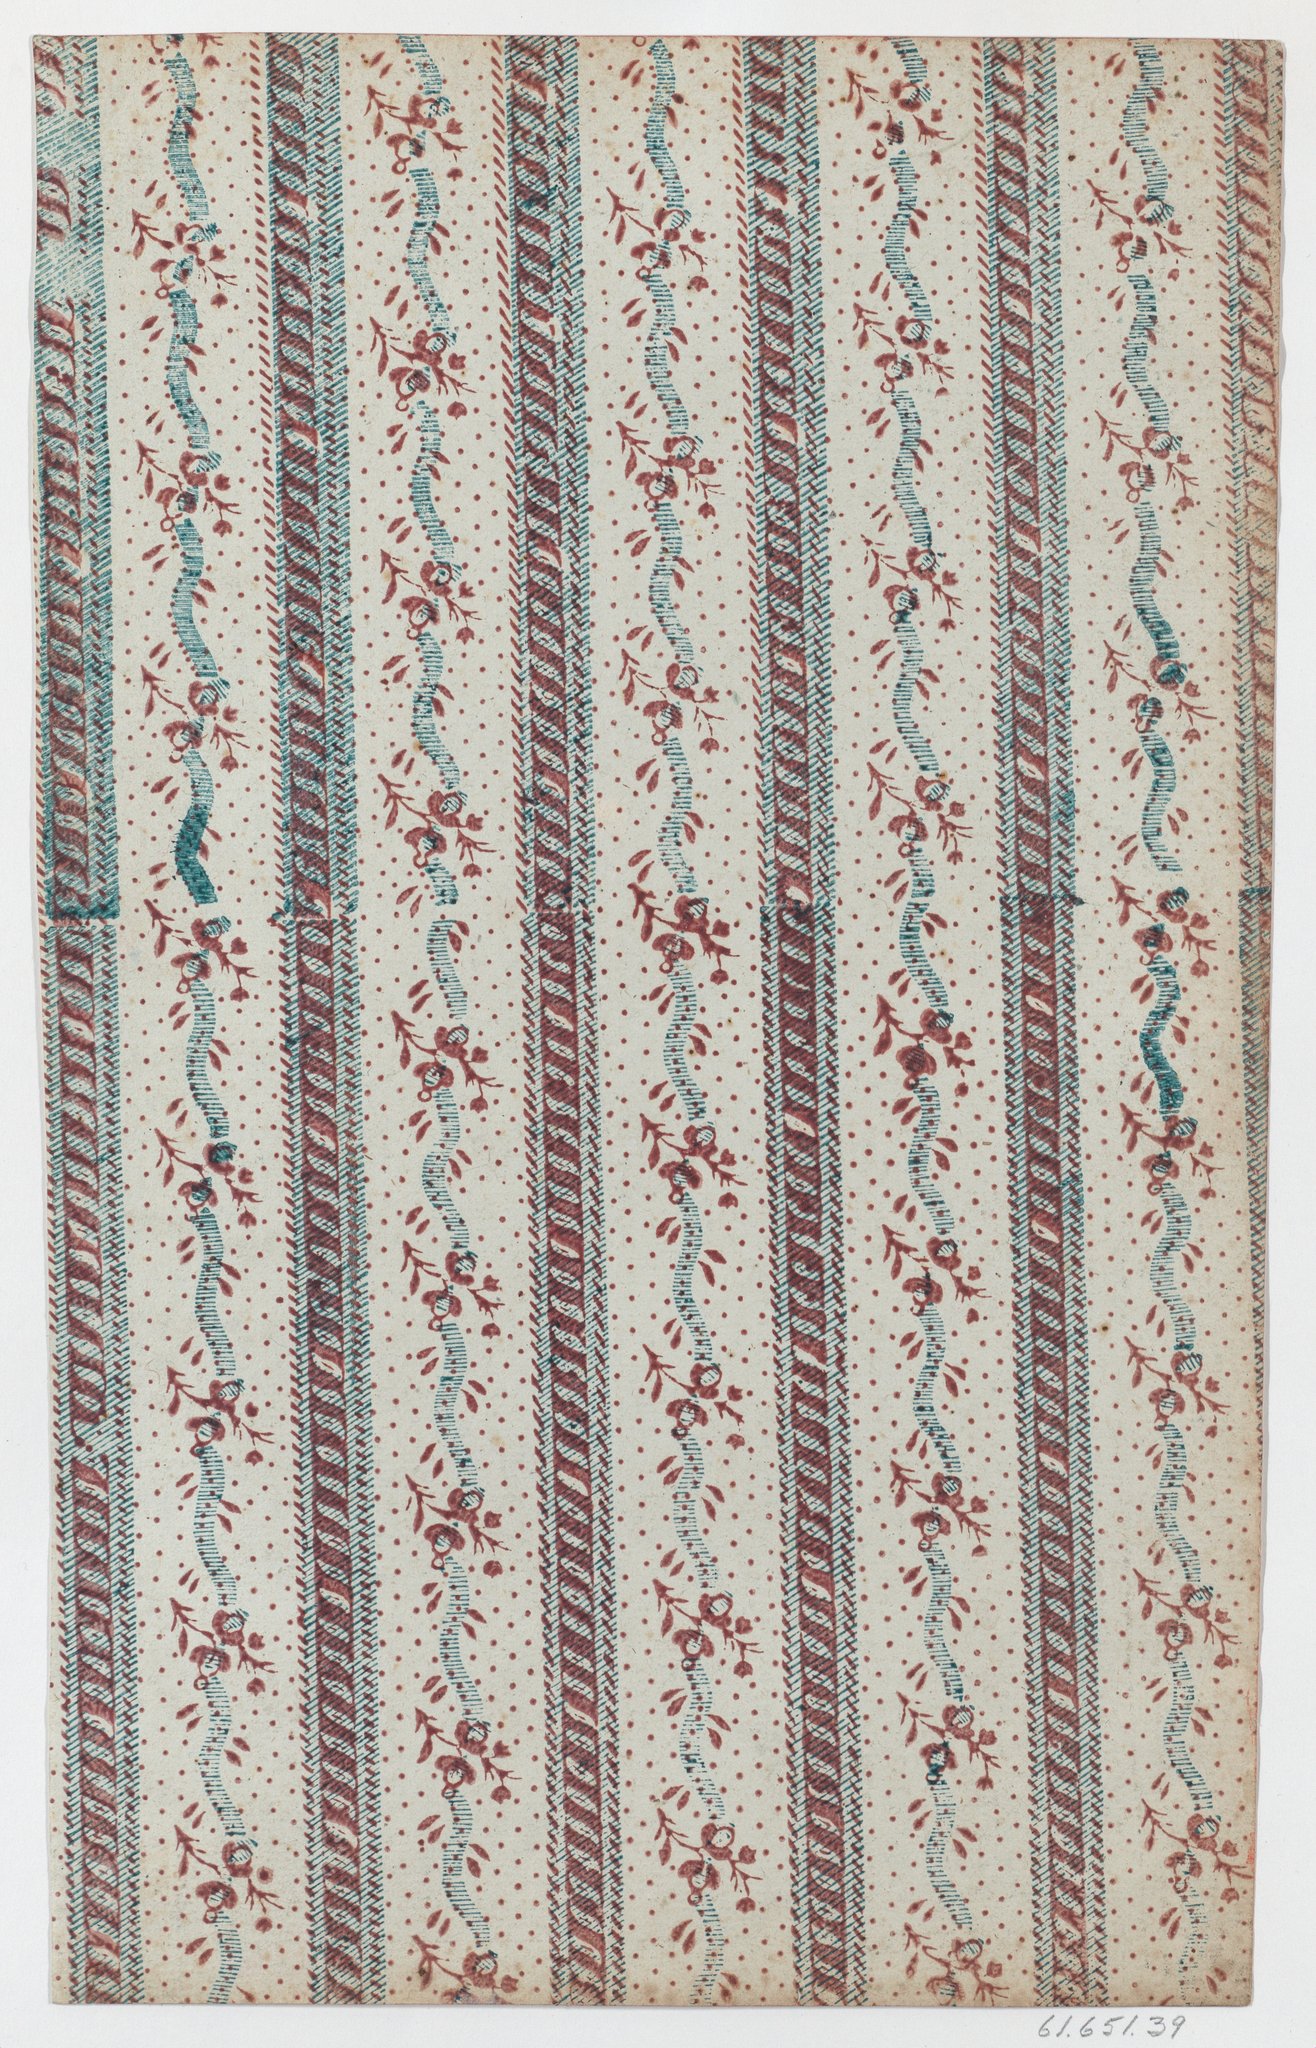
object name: print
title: Sheet with overall vine and dot pattern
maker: Anonymous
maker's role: artist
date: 1767-1866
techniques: relief print